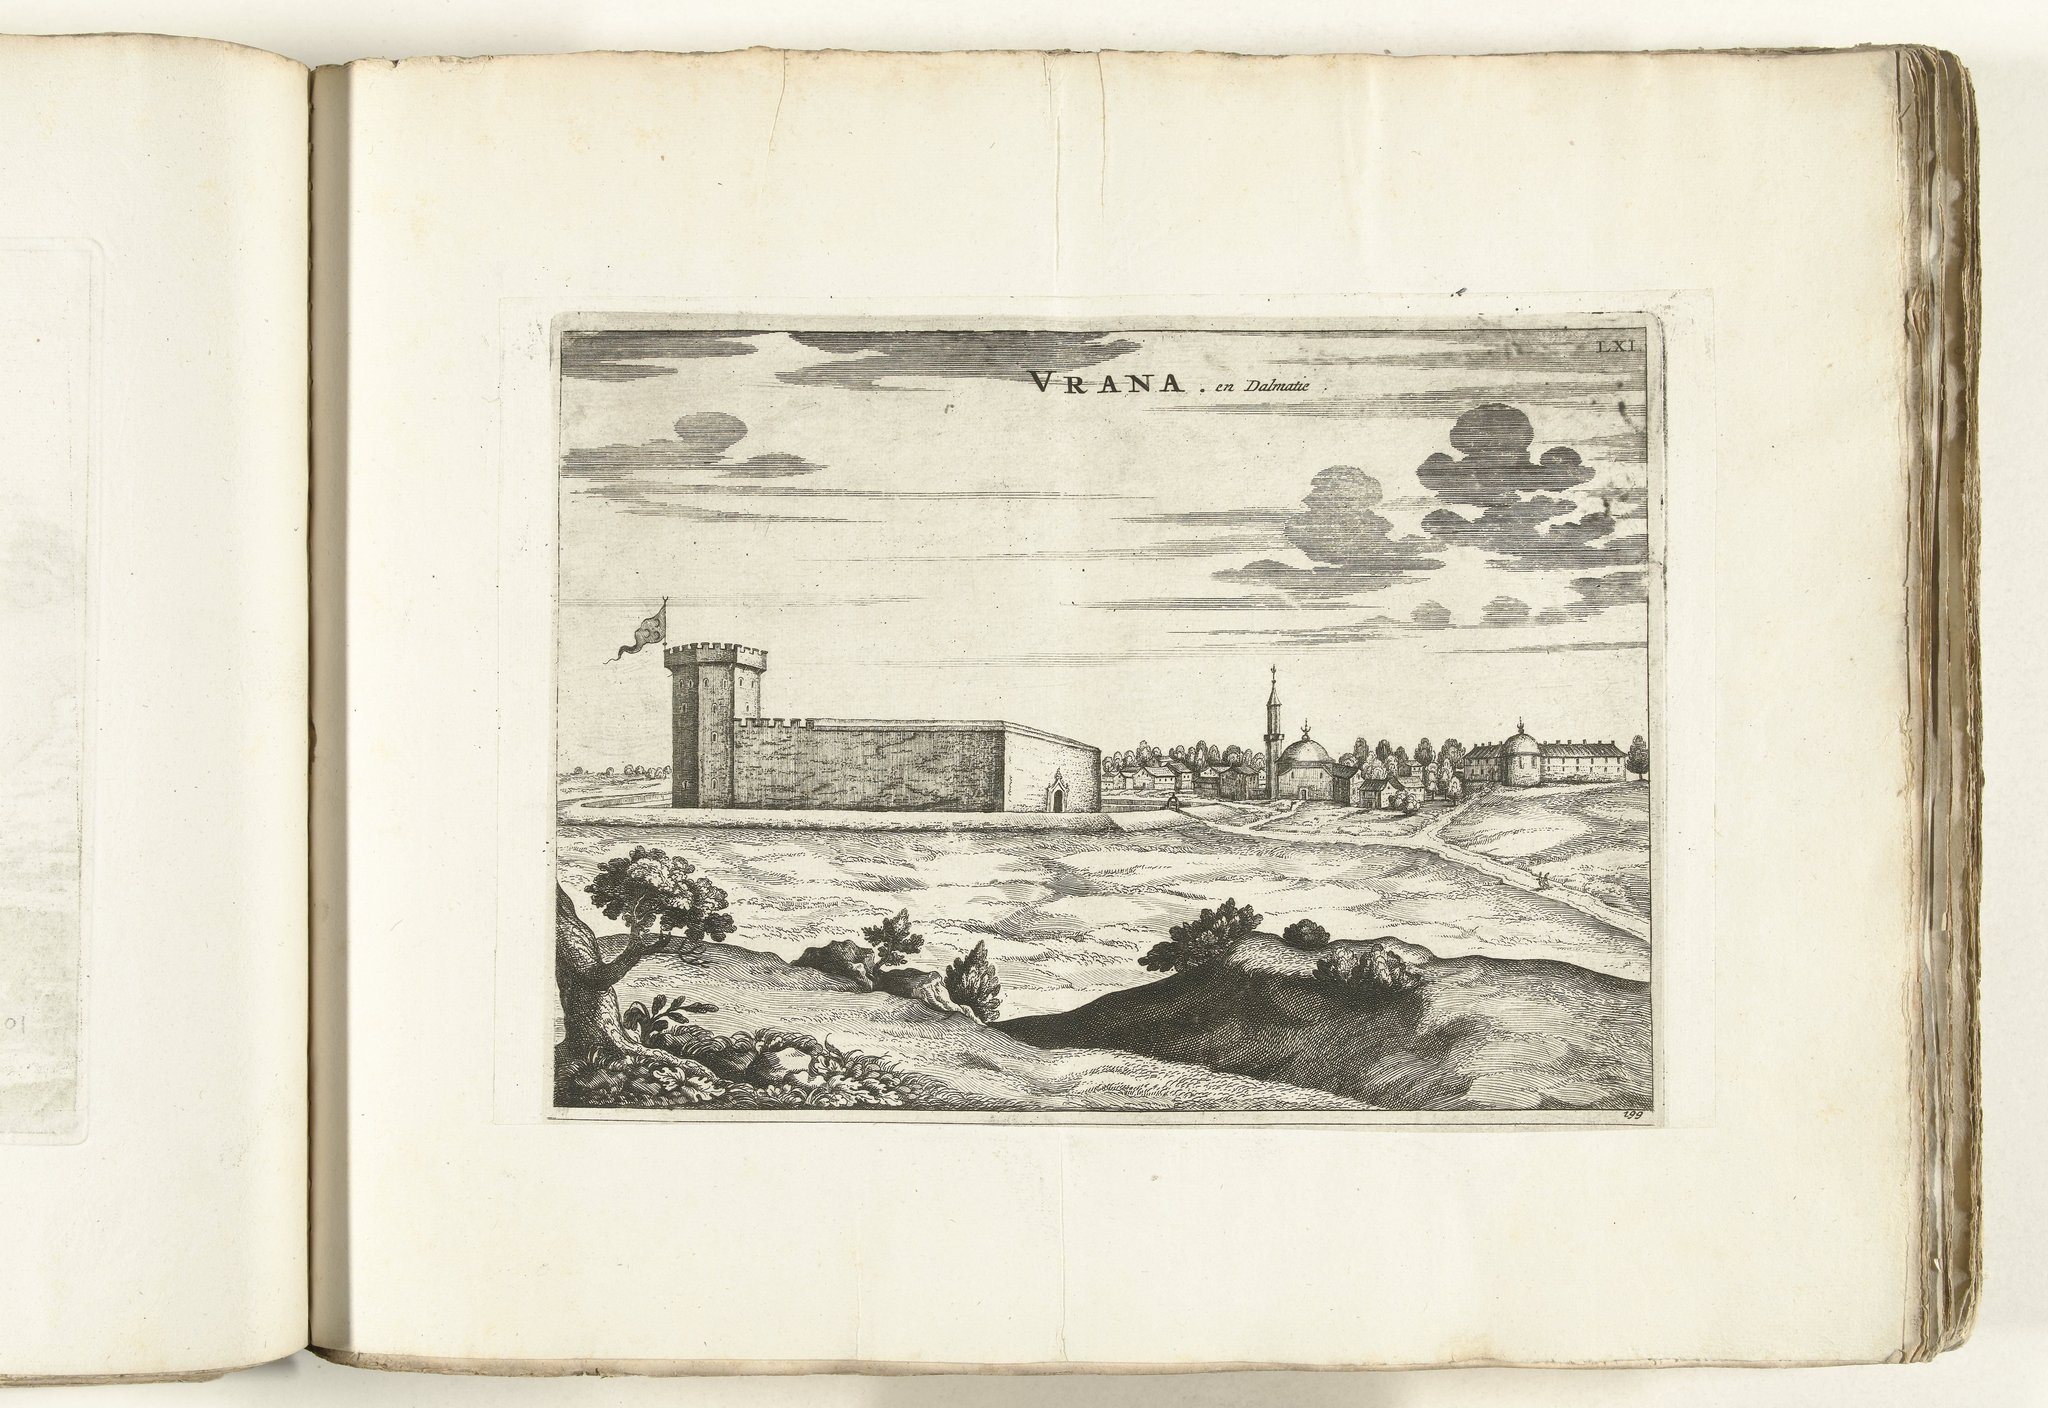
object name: print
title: Gezicht op het fort Vrana in Dalmatië, ca. 1702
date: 1702-1703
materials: paper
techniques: etching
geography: northern netherlands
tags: fortress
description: Gezicht op het fort Vrana in Dalmatië (Kroatië). Gemerkt rechtsboven: LXI. Plaat nr. 199 in het prentwerk bestaande in totaal uit 276 genummerde platen van vermaarde sterke steden en vestingen in het kader van de Spaanse Successieoorlog. Voor het merendeel zijn deze platen gekopieerd naar de anonieme Franse platen: in Les forces de l'Europe en in: Le theatre de la guerre, dans les Pays-Bas, beide oorspronkelijk uitgegeven door Nicolas de Fer te Parijs (1693-1697) in het kader van de Negenjarige Oorlog. Blad uitgeknipt en opgeplakt.